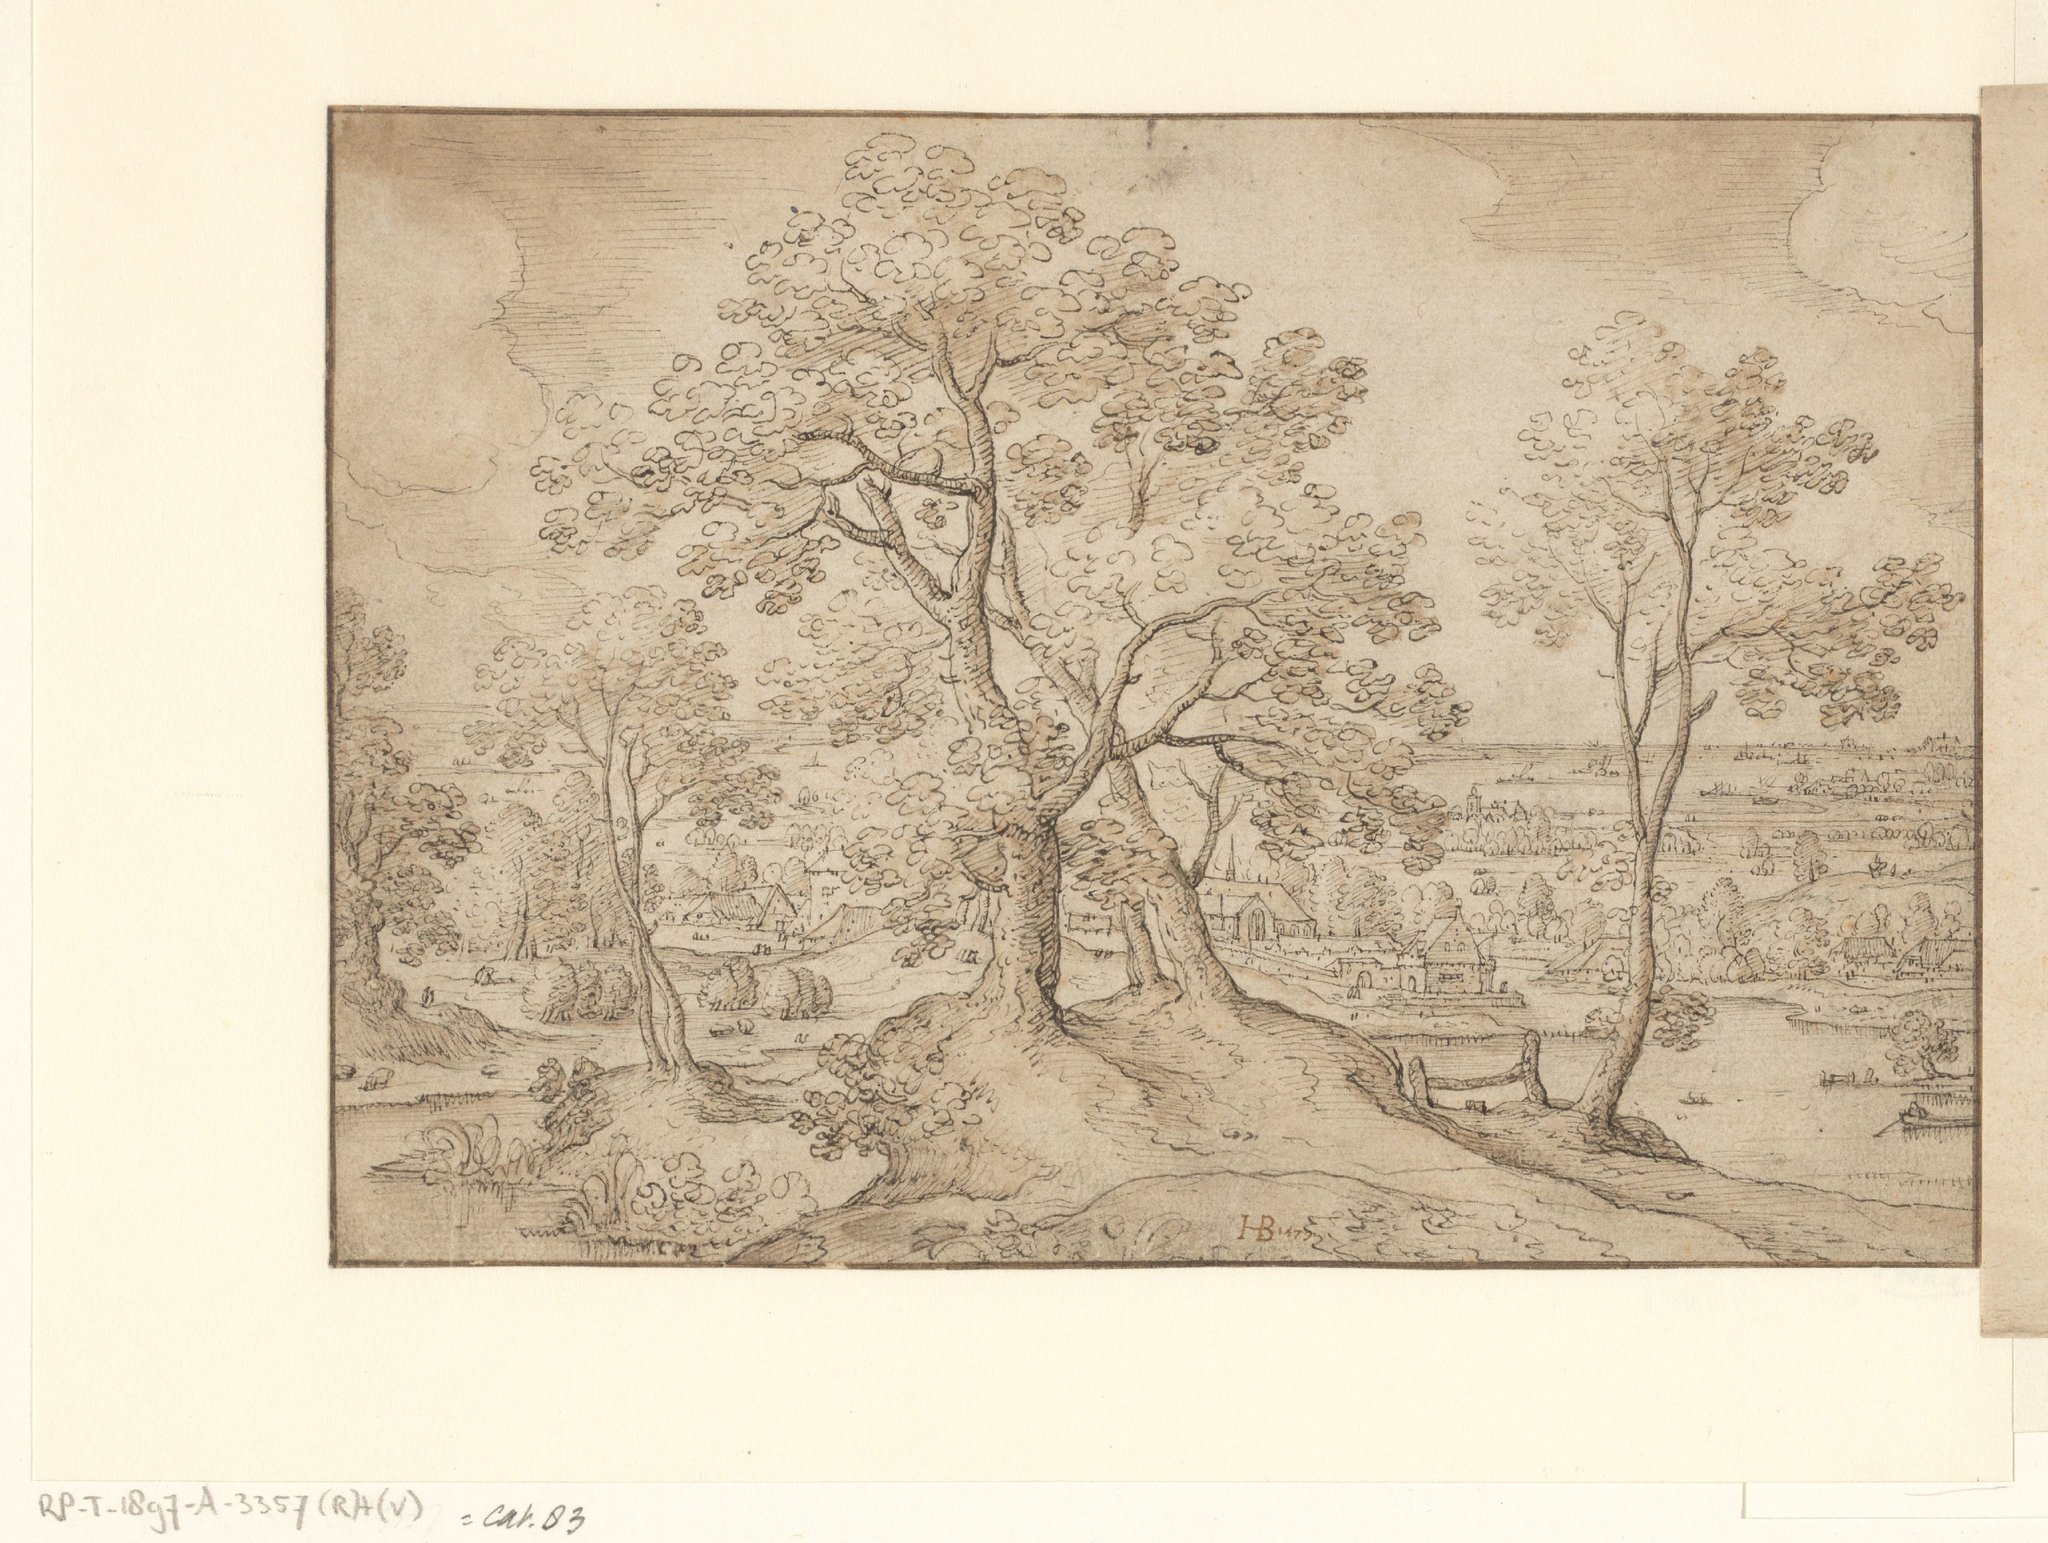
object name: drawing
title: Gezicht op een rivier die langs een dorp stroomt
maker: hans bol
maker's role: draughtsman, print maker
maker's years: 1534-1593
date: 1579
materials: ink, paper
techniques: brush, pen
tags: river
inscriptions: date